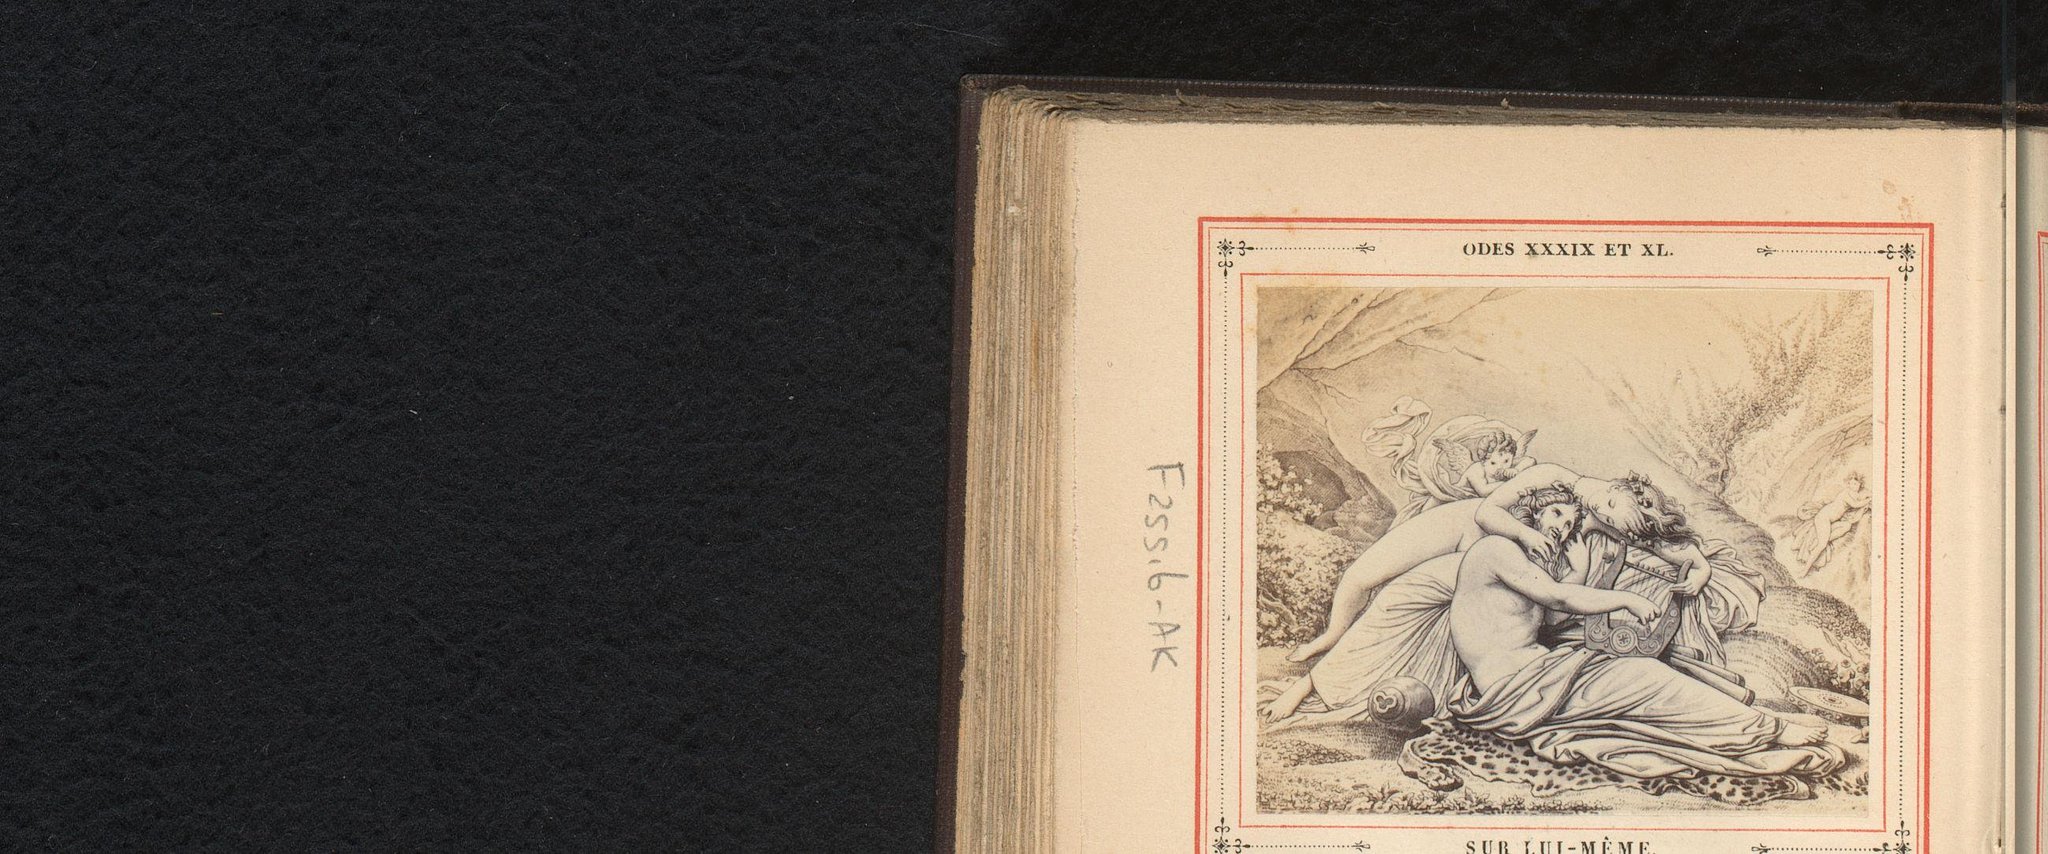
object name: page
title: Fotoreproductie van een tekening van Girodet, liefdespaar met een harp, illustratie bij Apothéose d'Anacréon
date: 1859-1864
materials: paper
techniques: albumen print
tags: gods ~ classical mythology